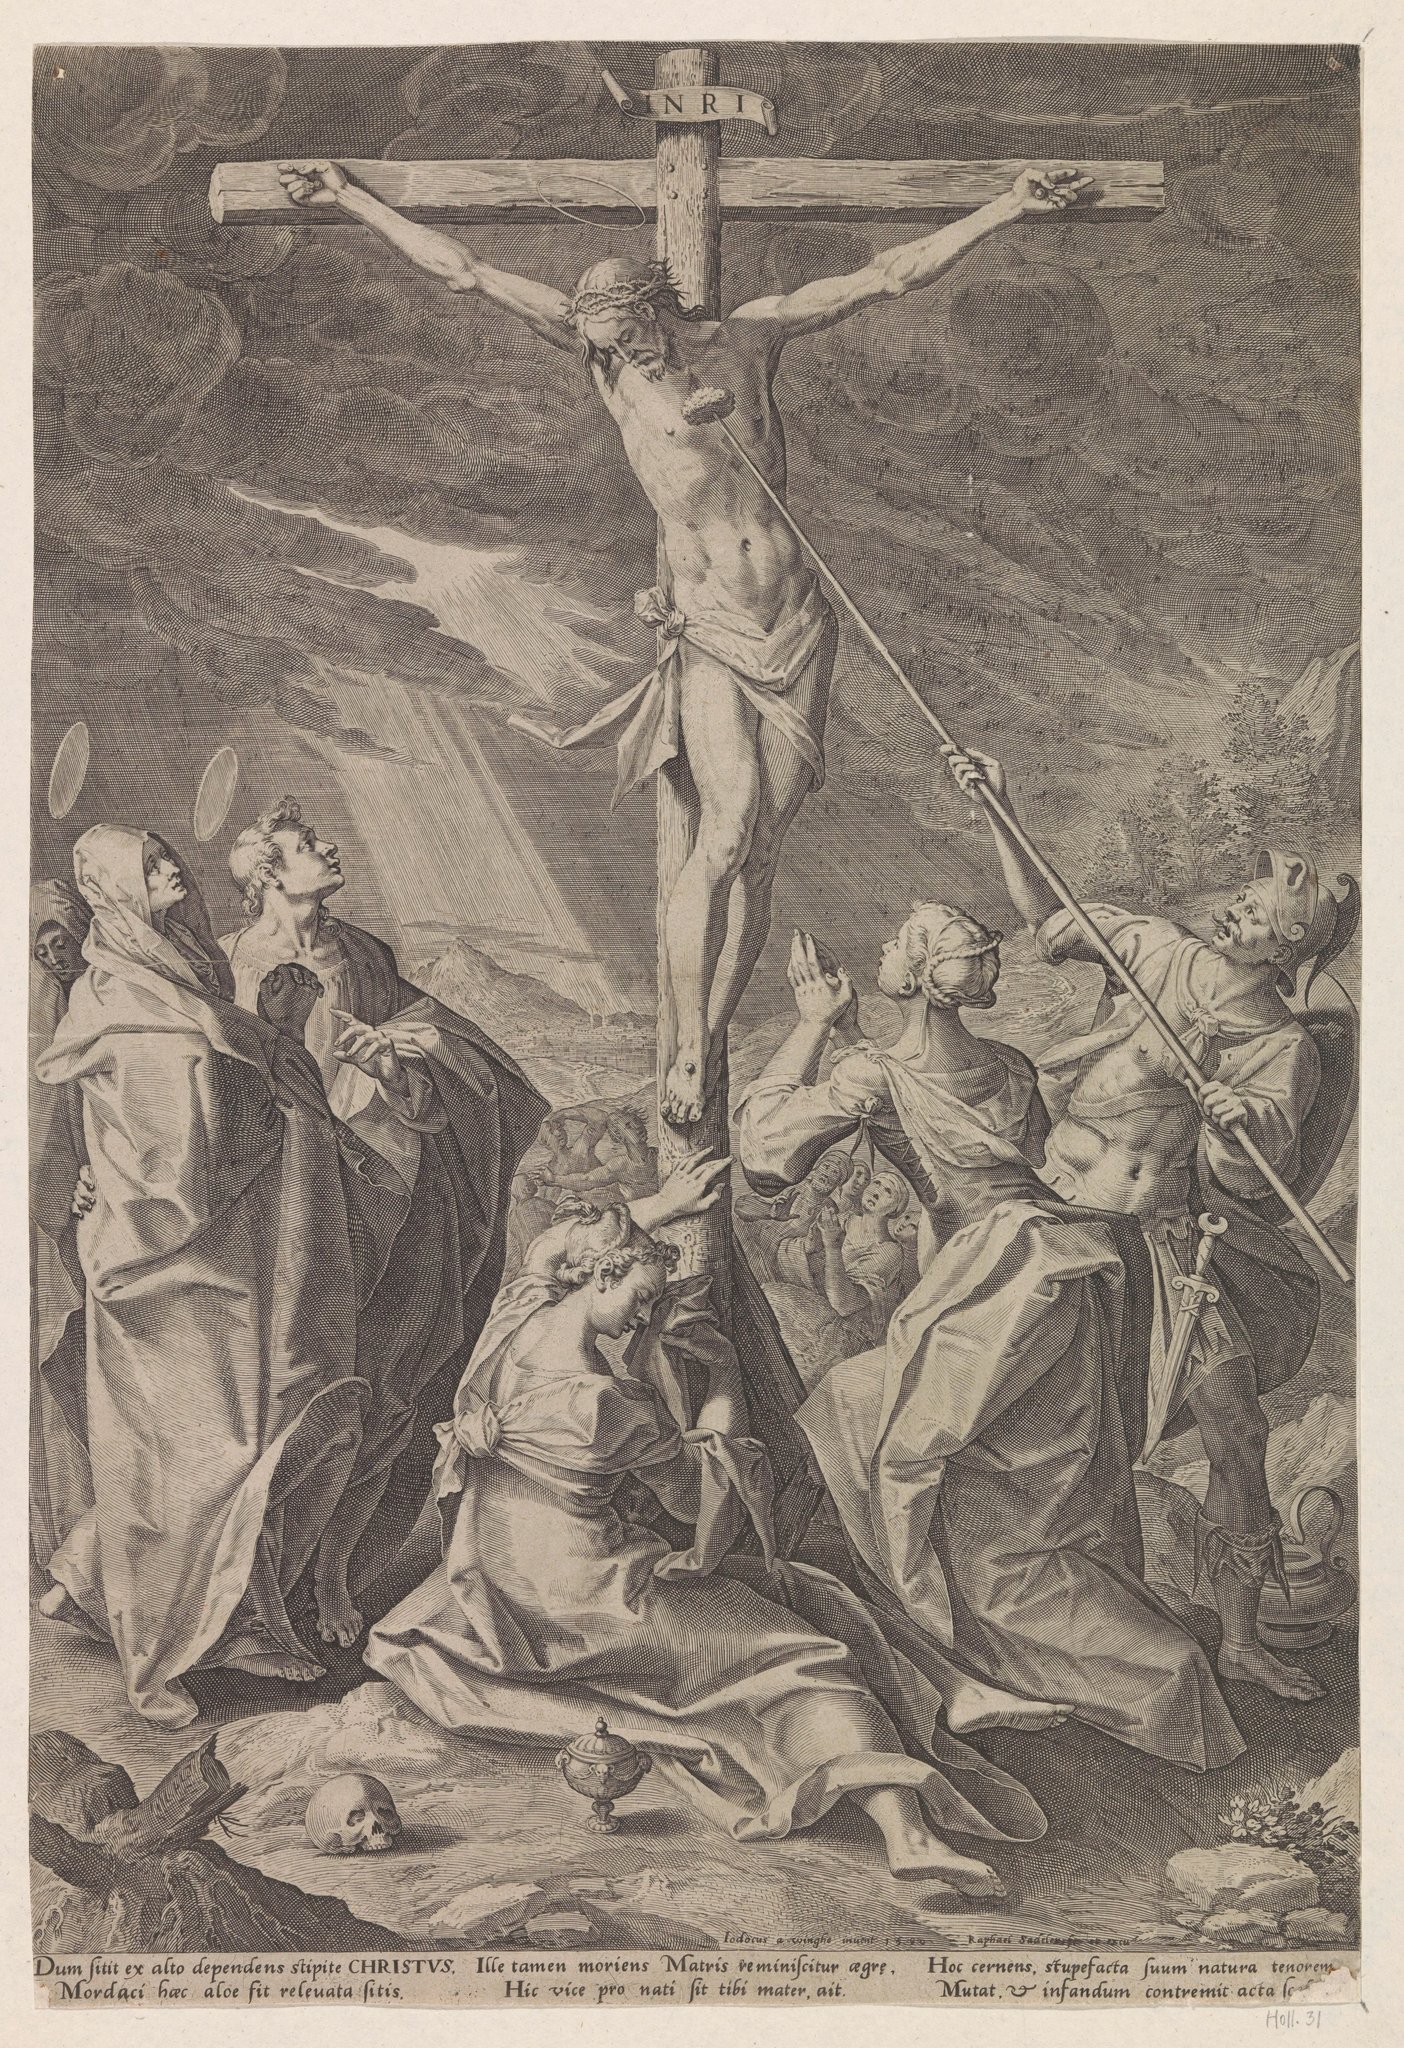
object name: print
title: Christus aan het kruis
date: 1590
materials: paper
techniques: engraving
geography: munich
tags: one of the soldiers (stephaton) gives christ vinegar on a sponge attached to a pole or lance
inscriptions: collector's mark: Lugt 2228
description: Christus aan het kruis. Links de maagd Maria en de apostel Johannes. Maria Magdalena zit onder het kruis en huilt. Rechts een soldaat die Christus een spons doordrenkt met azijn aanbiedt.